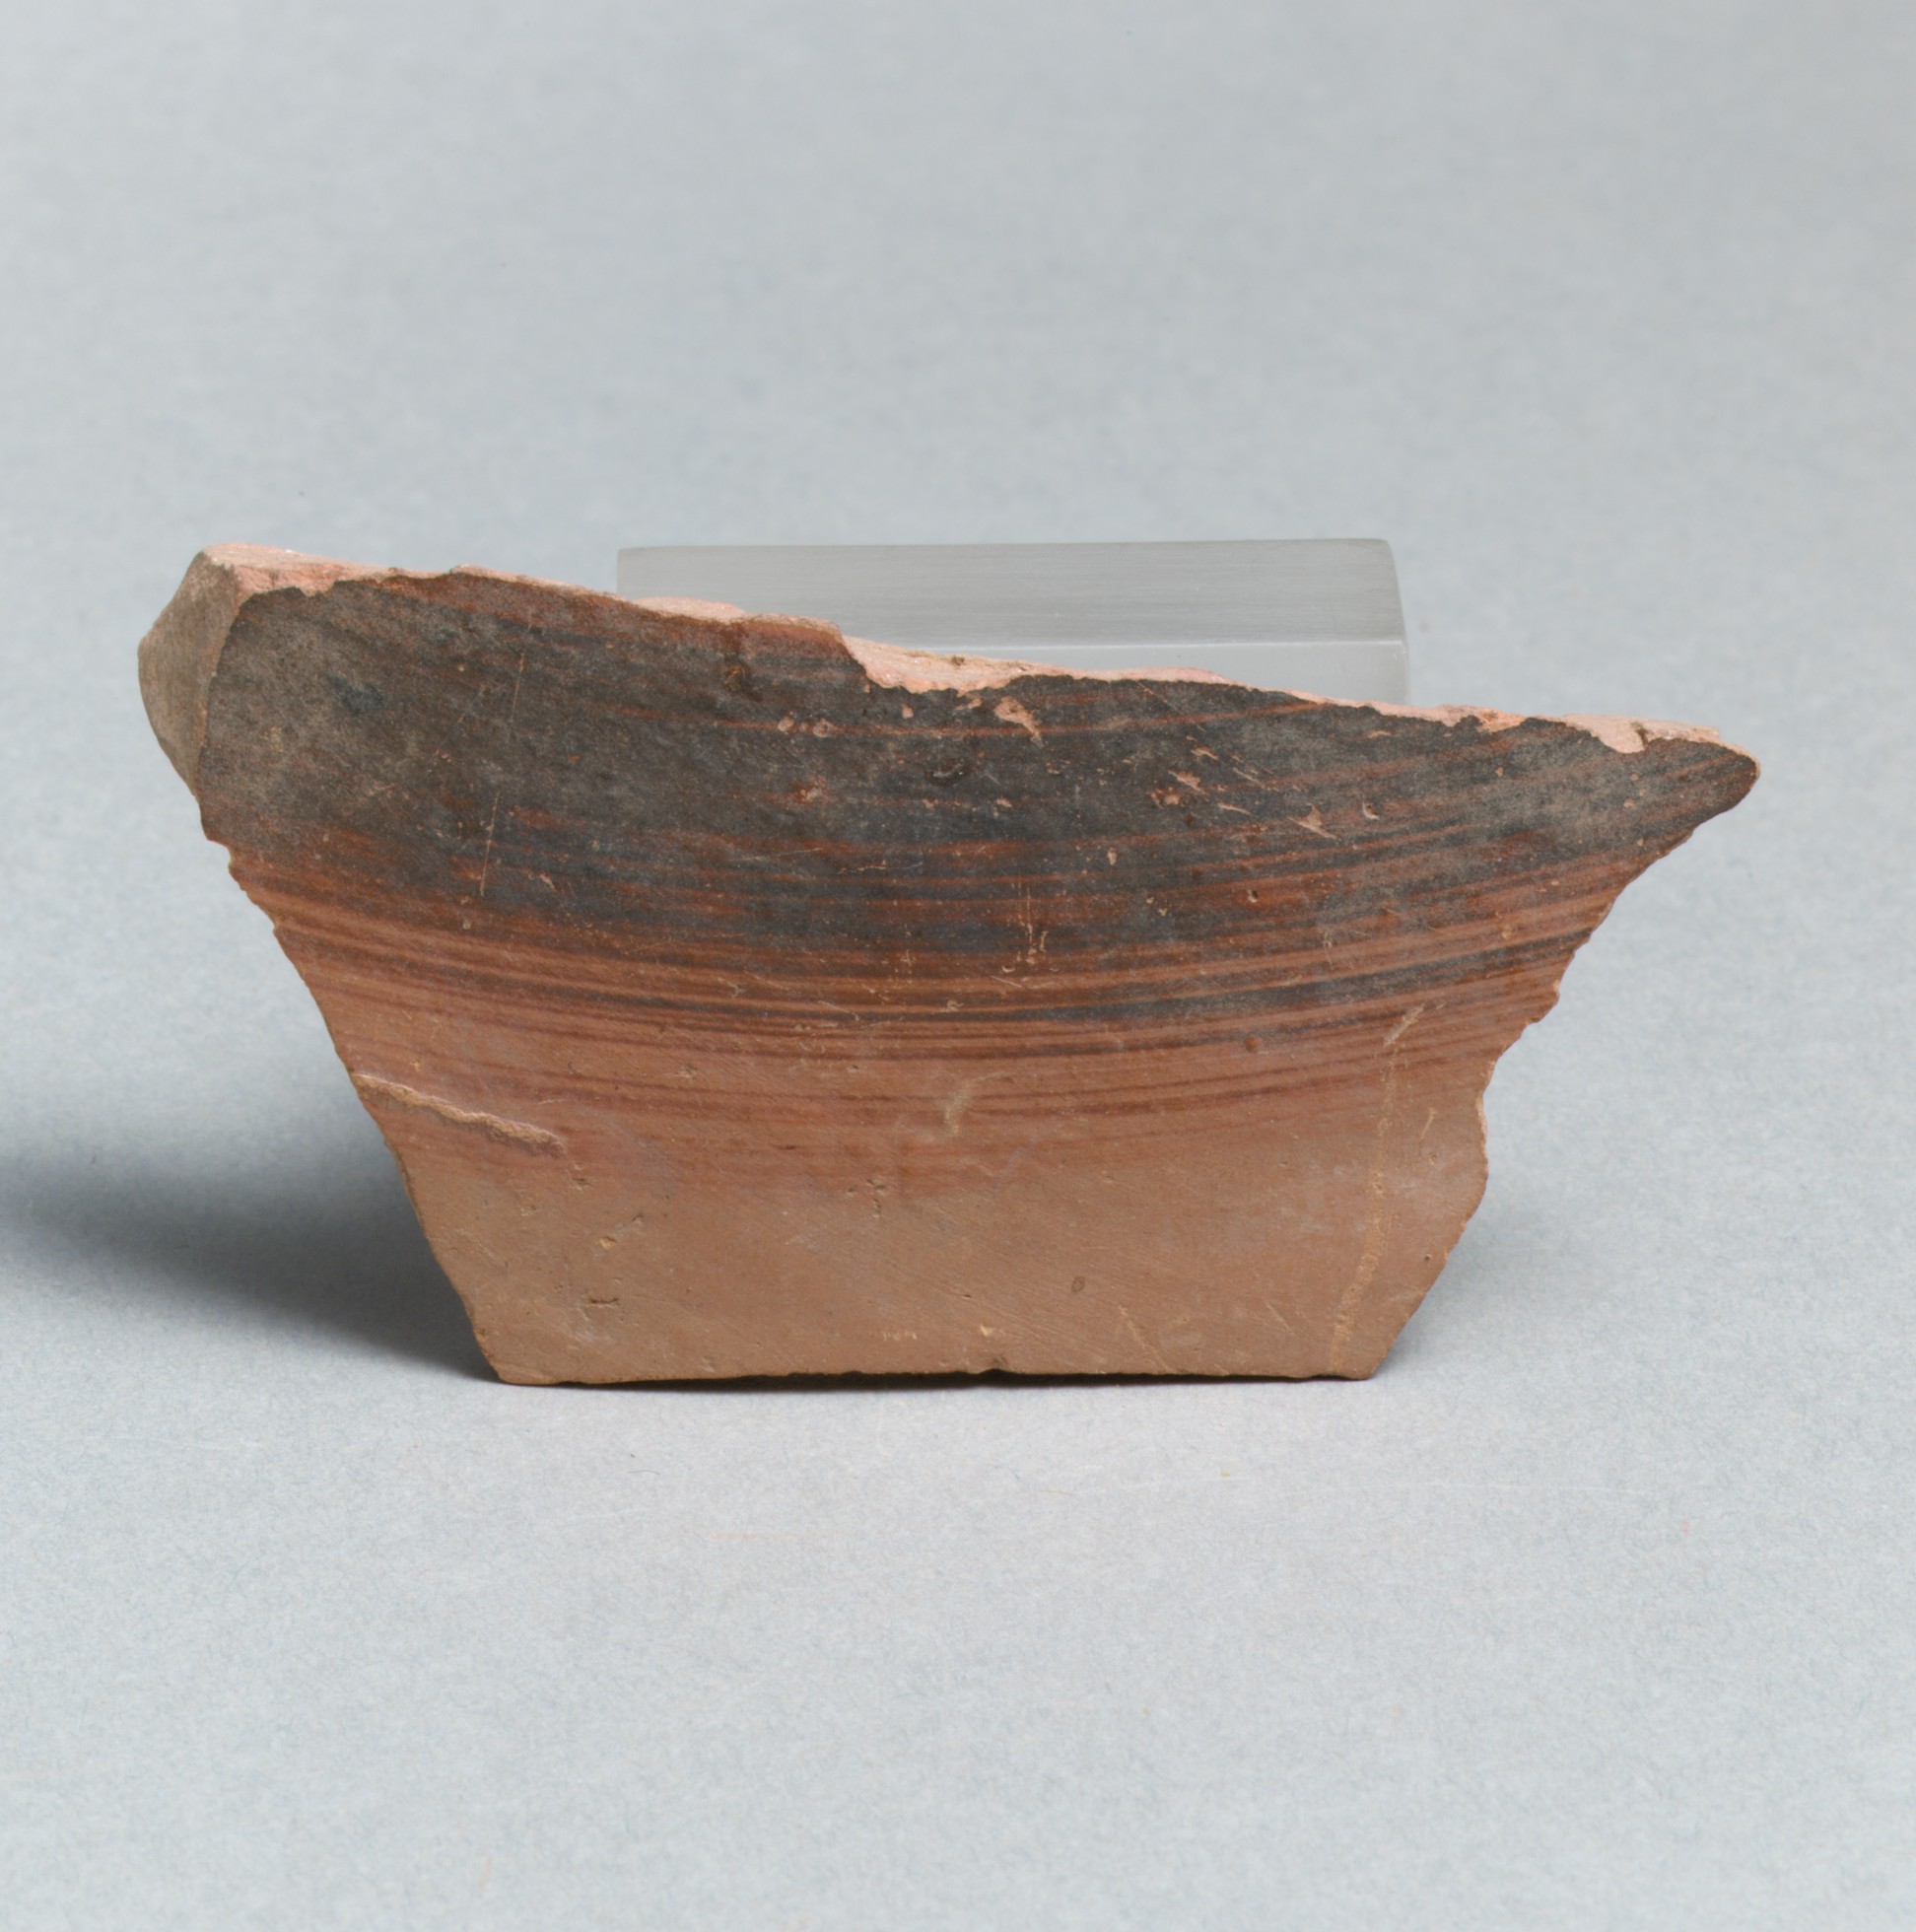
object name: vase fragment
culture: greek or lydian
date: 900-30 BCE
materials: terracotta